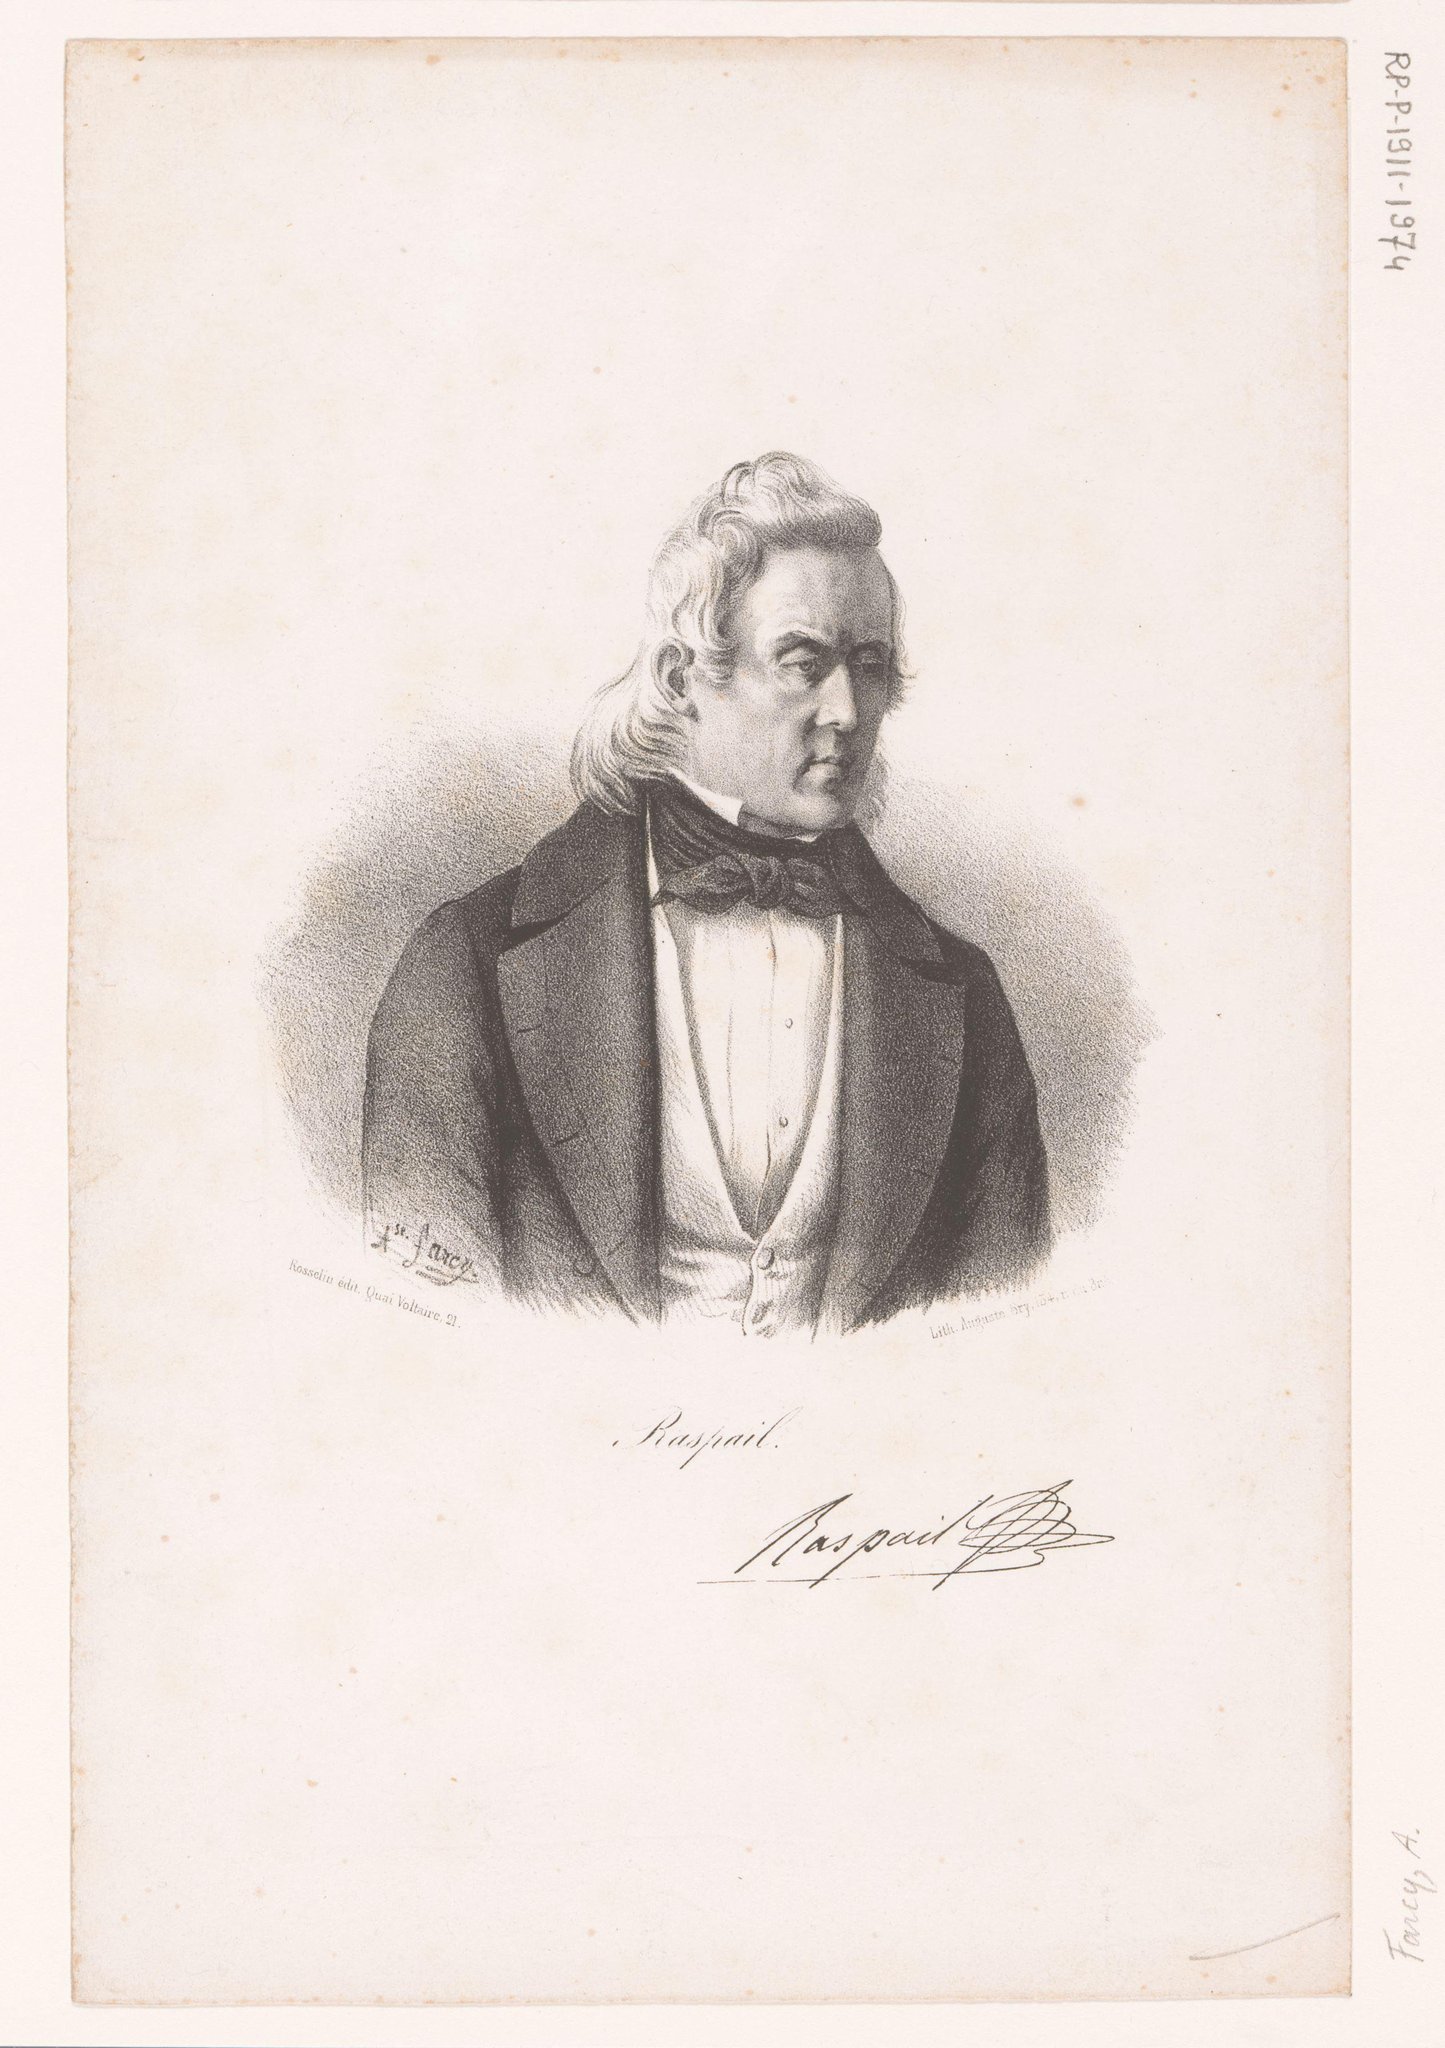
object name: print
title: Portret van François-Vincent Raspail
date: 1848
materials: paper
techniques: lithograph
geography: paris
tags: politician, historical persons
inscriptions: collector's mark: Lugt 2228a